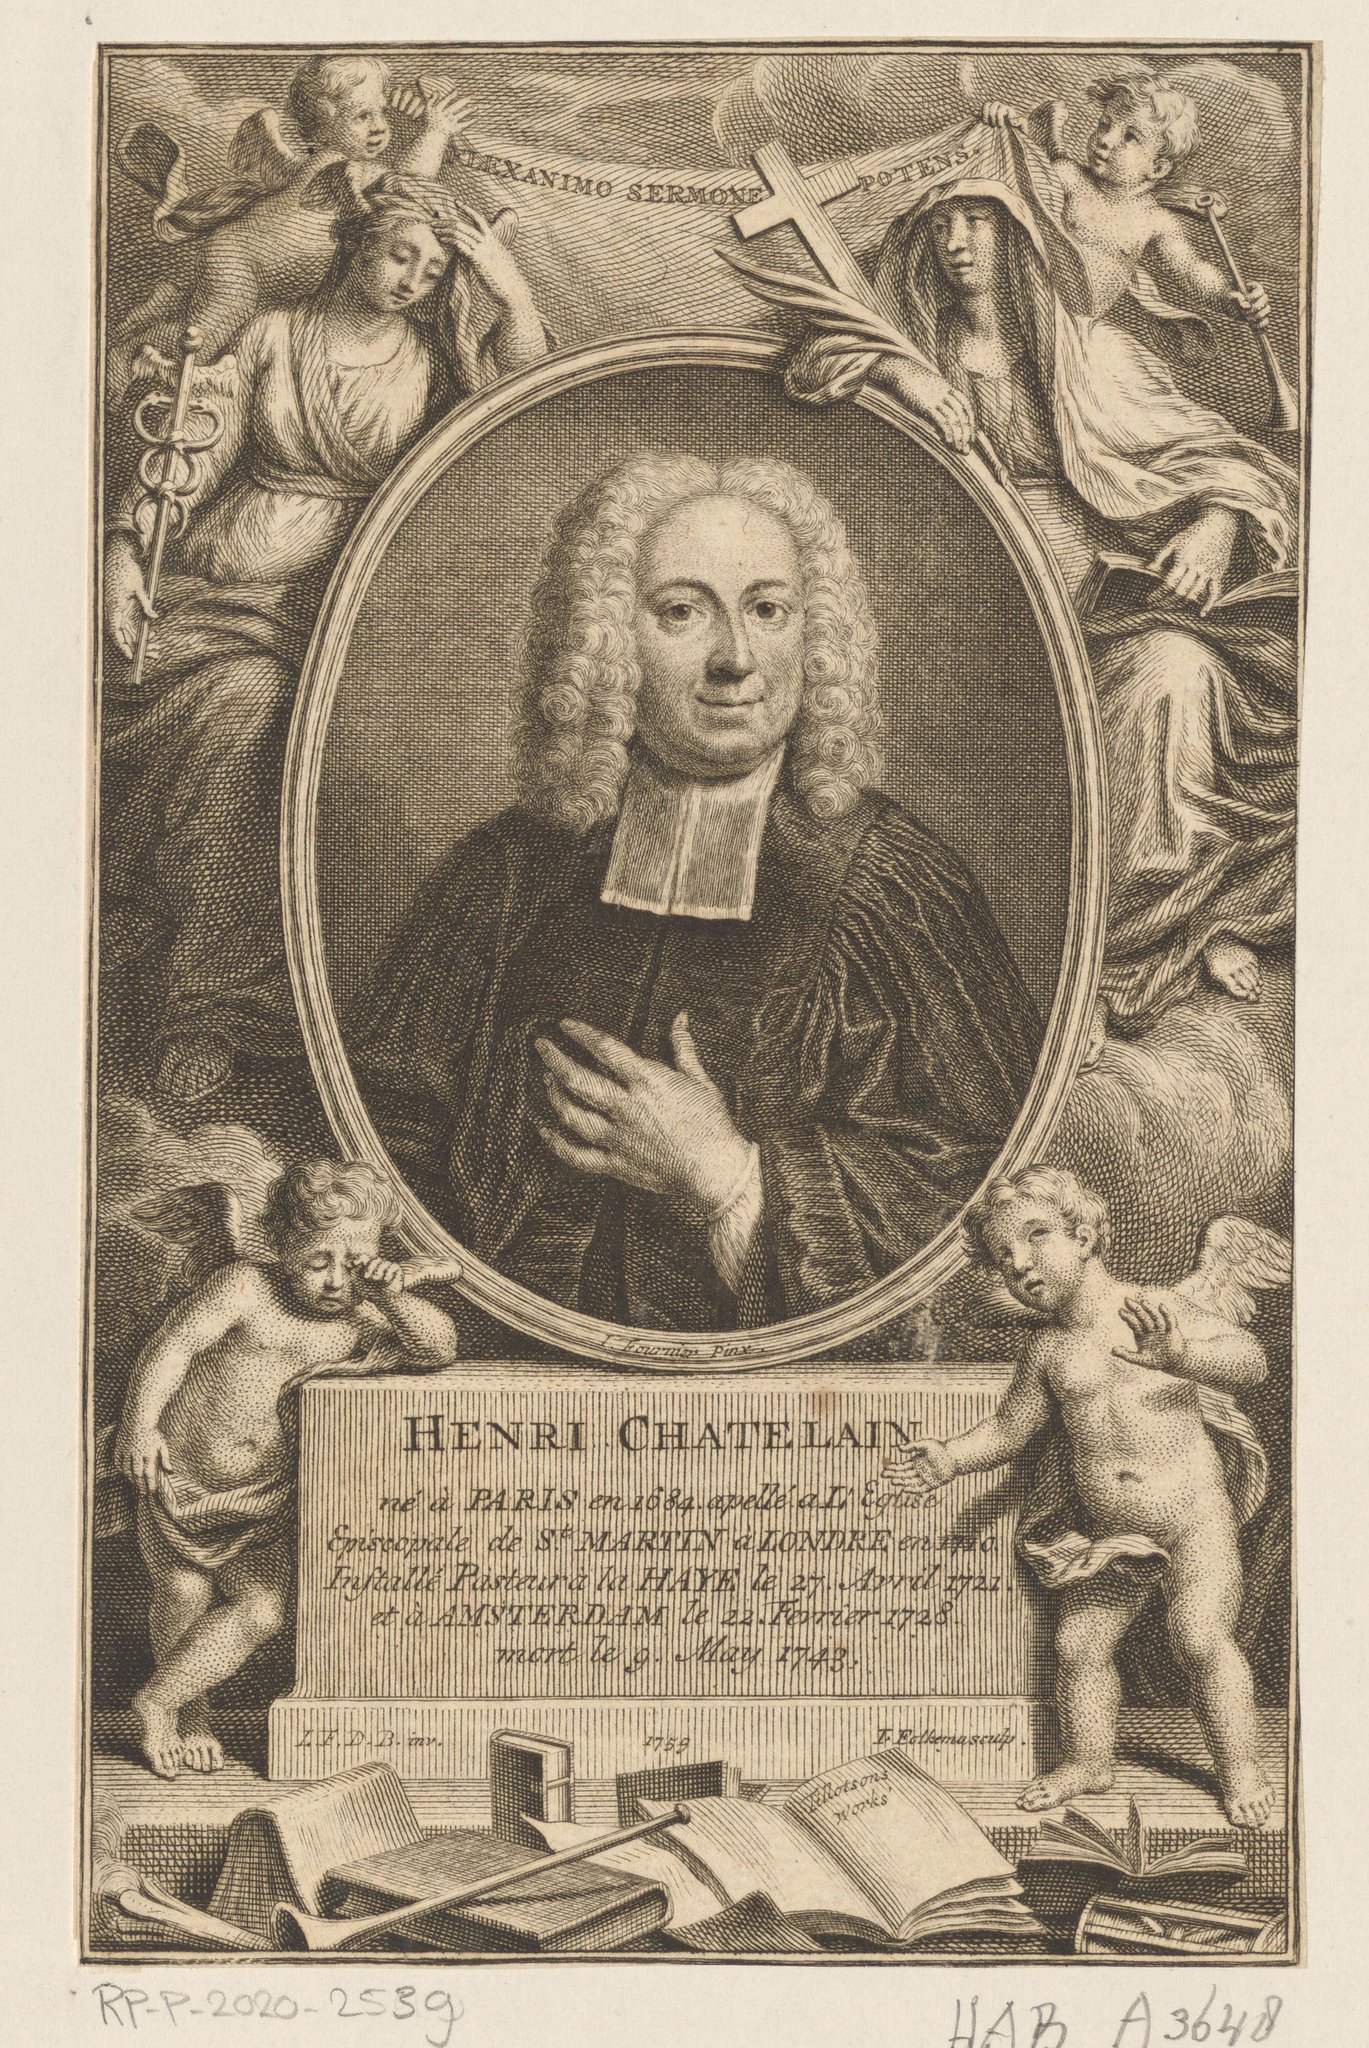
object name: print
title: Portret van Henri Chatelain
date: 1759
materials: paper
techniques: engraving, etching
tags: paris, amsterdam, historical persons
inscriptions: date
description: Het portret wordt omgeven door allegorische figuren. Bovenaan de personificaties Vrede (met caduceus en petasus) en Geloof (met kruis). Bij de sokkel staat een treurende putto en een putto die op boeken, een gedoofde toorts en een zandloper wijst.